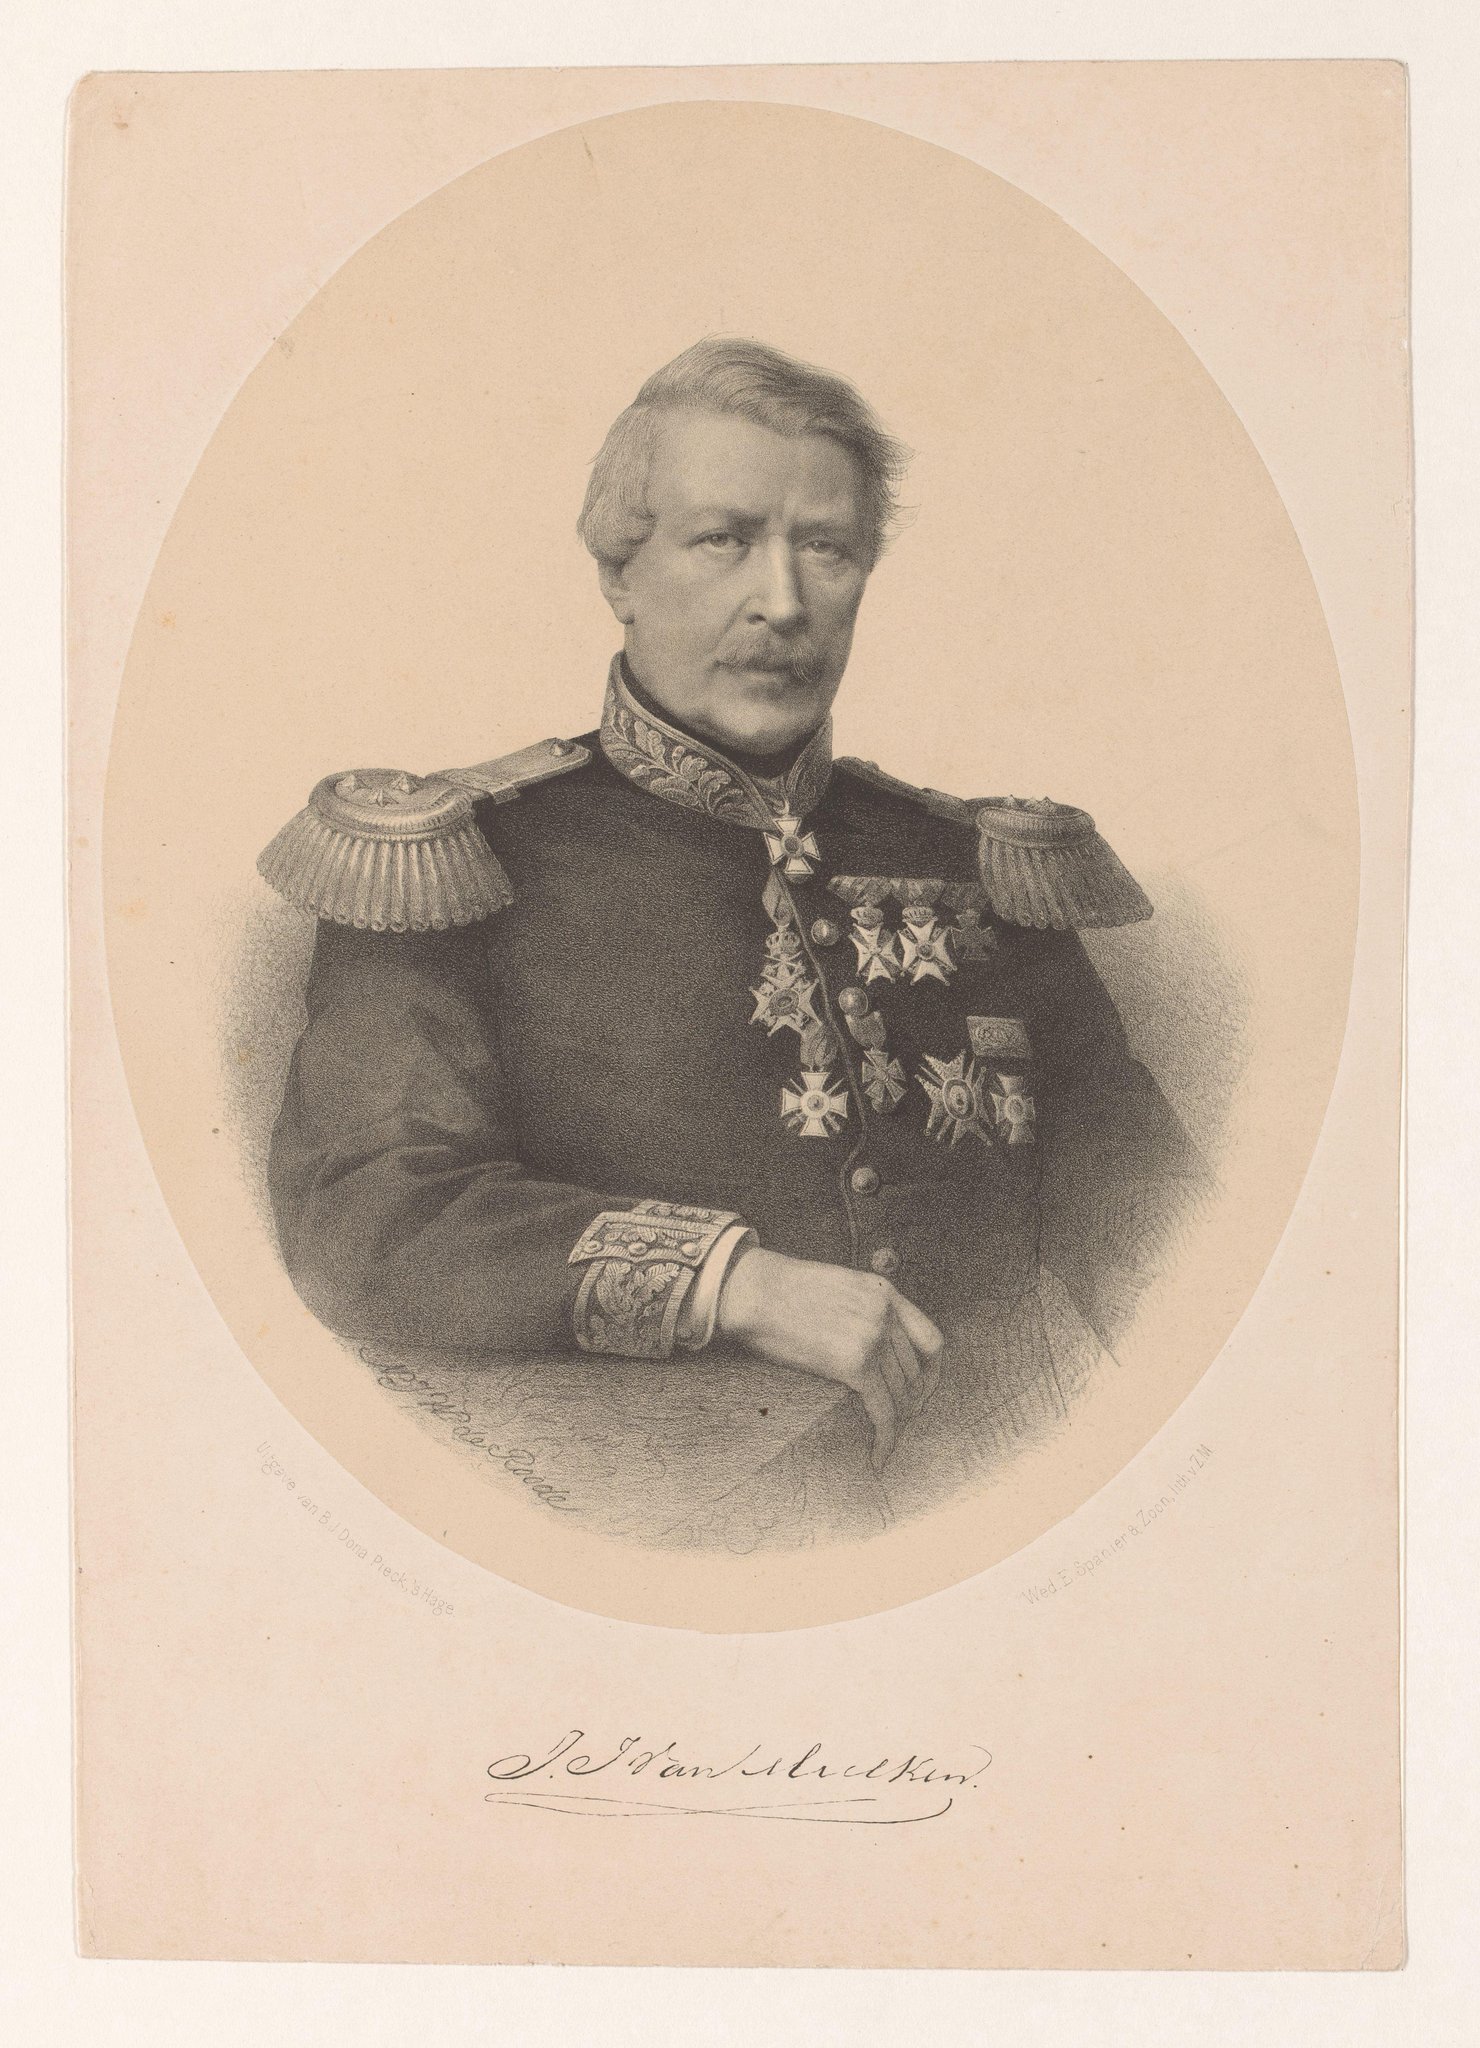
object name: print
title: Portret van Joannes Josephus van Mulken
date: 1869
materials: paper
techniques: lithograph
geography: the hague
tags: historical persons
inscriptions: collector's mark: Lugt 2228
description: Onder het portret de signatuur van de geportretteerde.